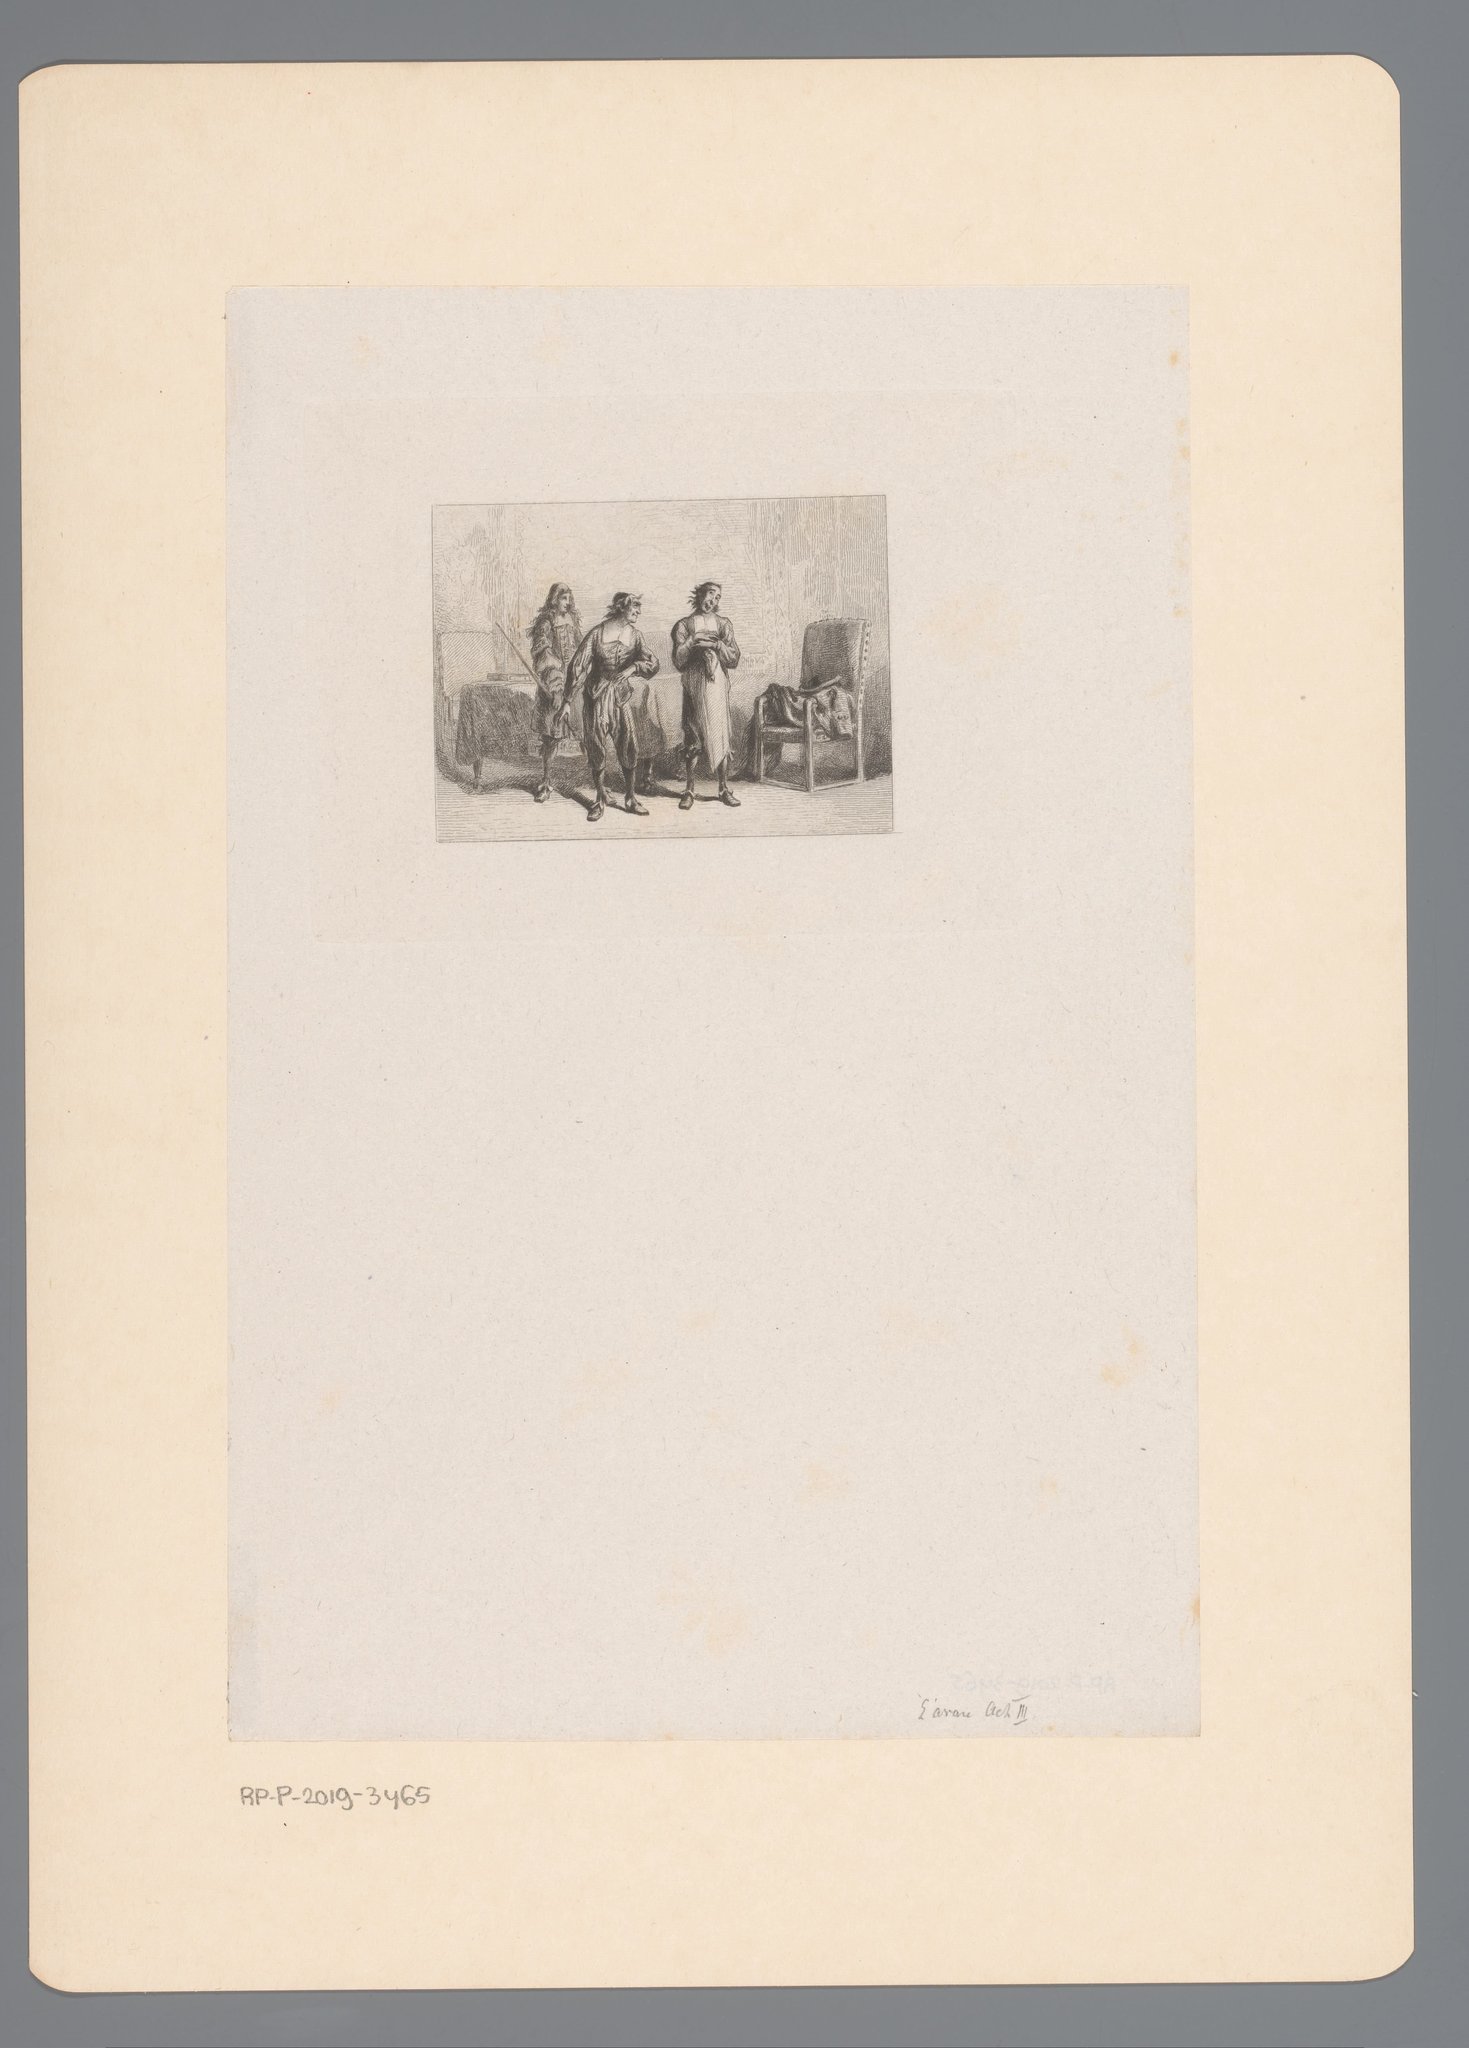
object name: print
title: Harpagon en Maître Jacques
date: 1878-1879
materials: paper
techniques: drypoint, etching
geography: tours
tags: relation between master and servant, theatre, theatrical performance, miser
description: Scène uit akte III uit "L'Avare" van Molière. Waarschijnlijk betreft het hier Harpagon die zijn kok Maître Jacques wil straffen met stokslagen omdat hij te veel geld wilde uitgeven voor de maaltijd.